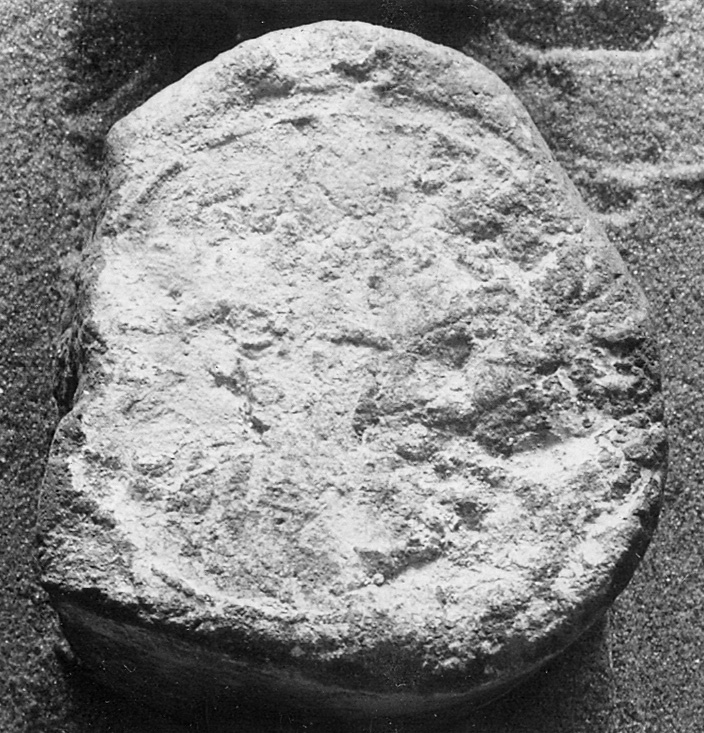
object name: cone, circular impression, baki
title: Funerary Cone of Baki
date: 1550-1295 BCE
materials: pottery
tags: hieroglyphs